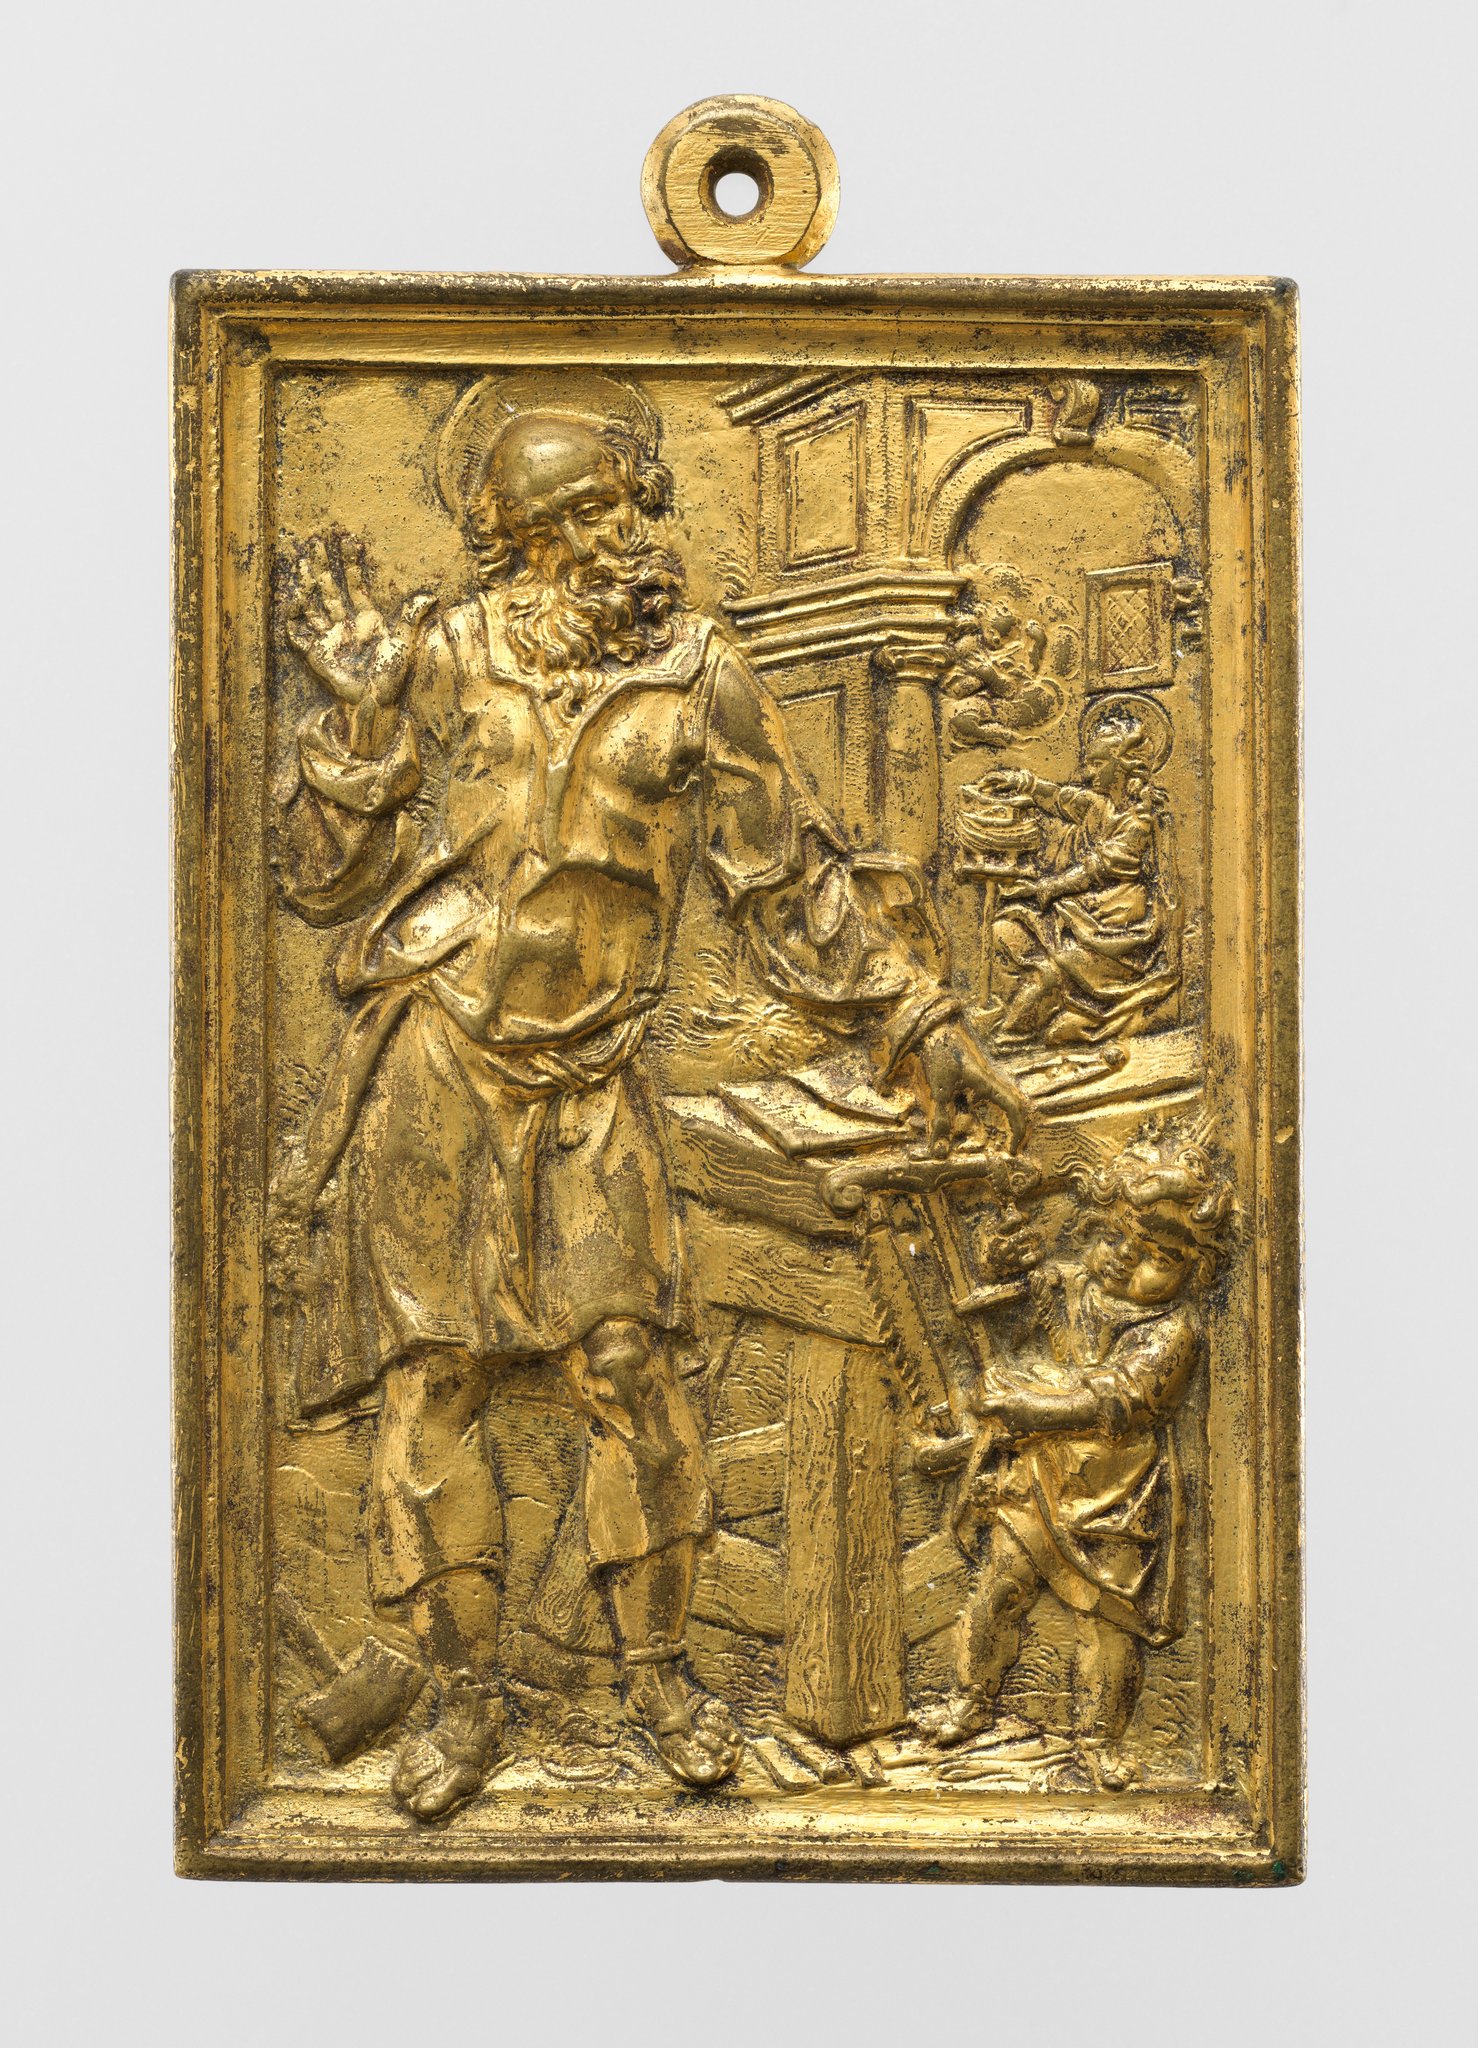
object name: plaquette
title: Christ Child and Saint Joseph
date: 1601-1633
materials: gilt bronze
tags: christ,saint joseph,virgin mary